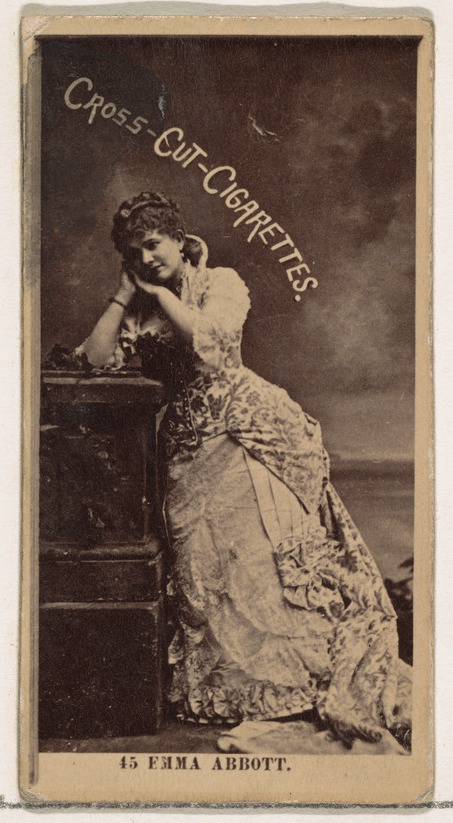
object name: print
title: Card Number 45, Emma Abbott, from the Actors and Actresses series (N145-2) issued by Duke Sons & Co. to promote Cross Cut Cigarettes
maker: w. duke, sons & co.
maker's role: publisher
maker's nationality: american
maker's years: 1870-1920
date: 1880-1889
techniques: albumen silver print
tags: portraits,women,actresses